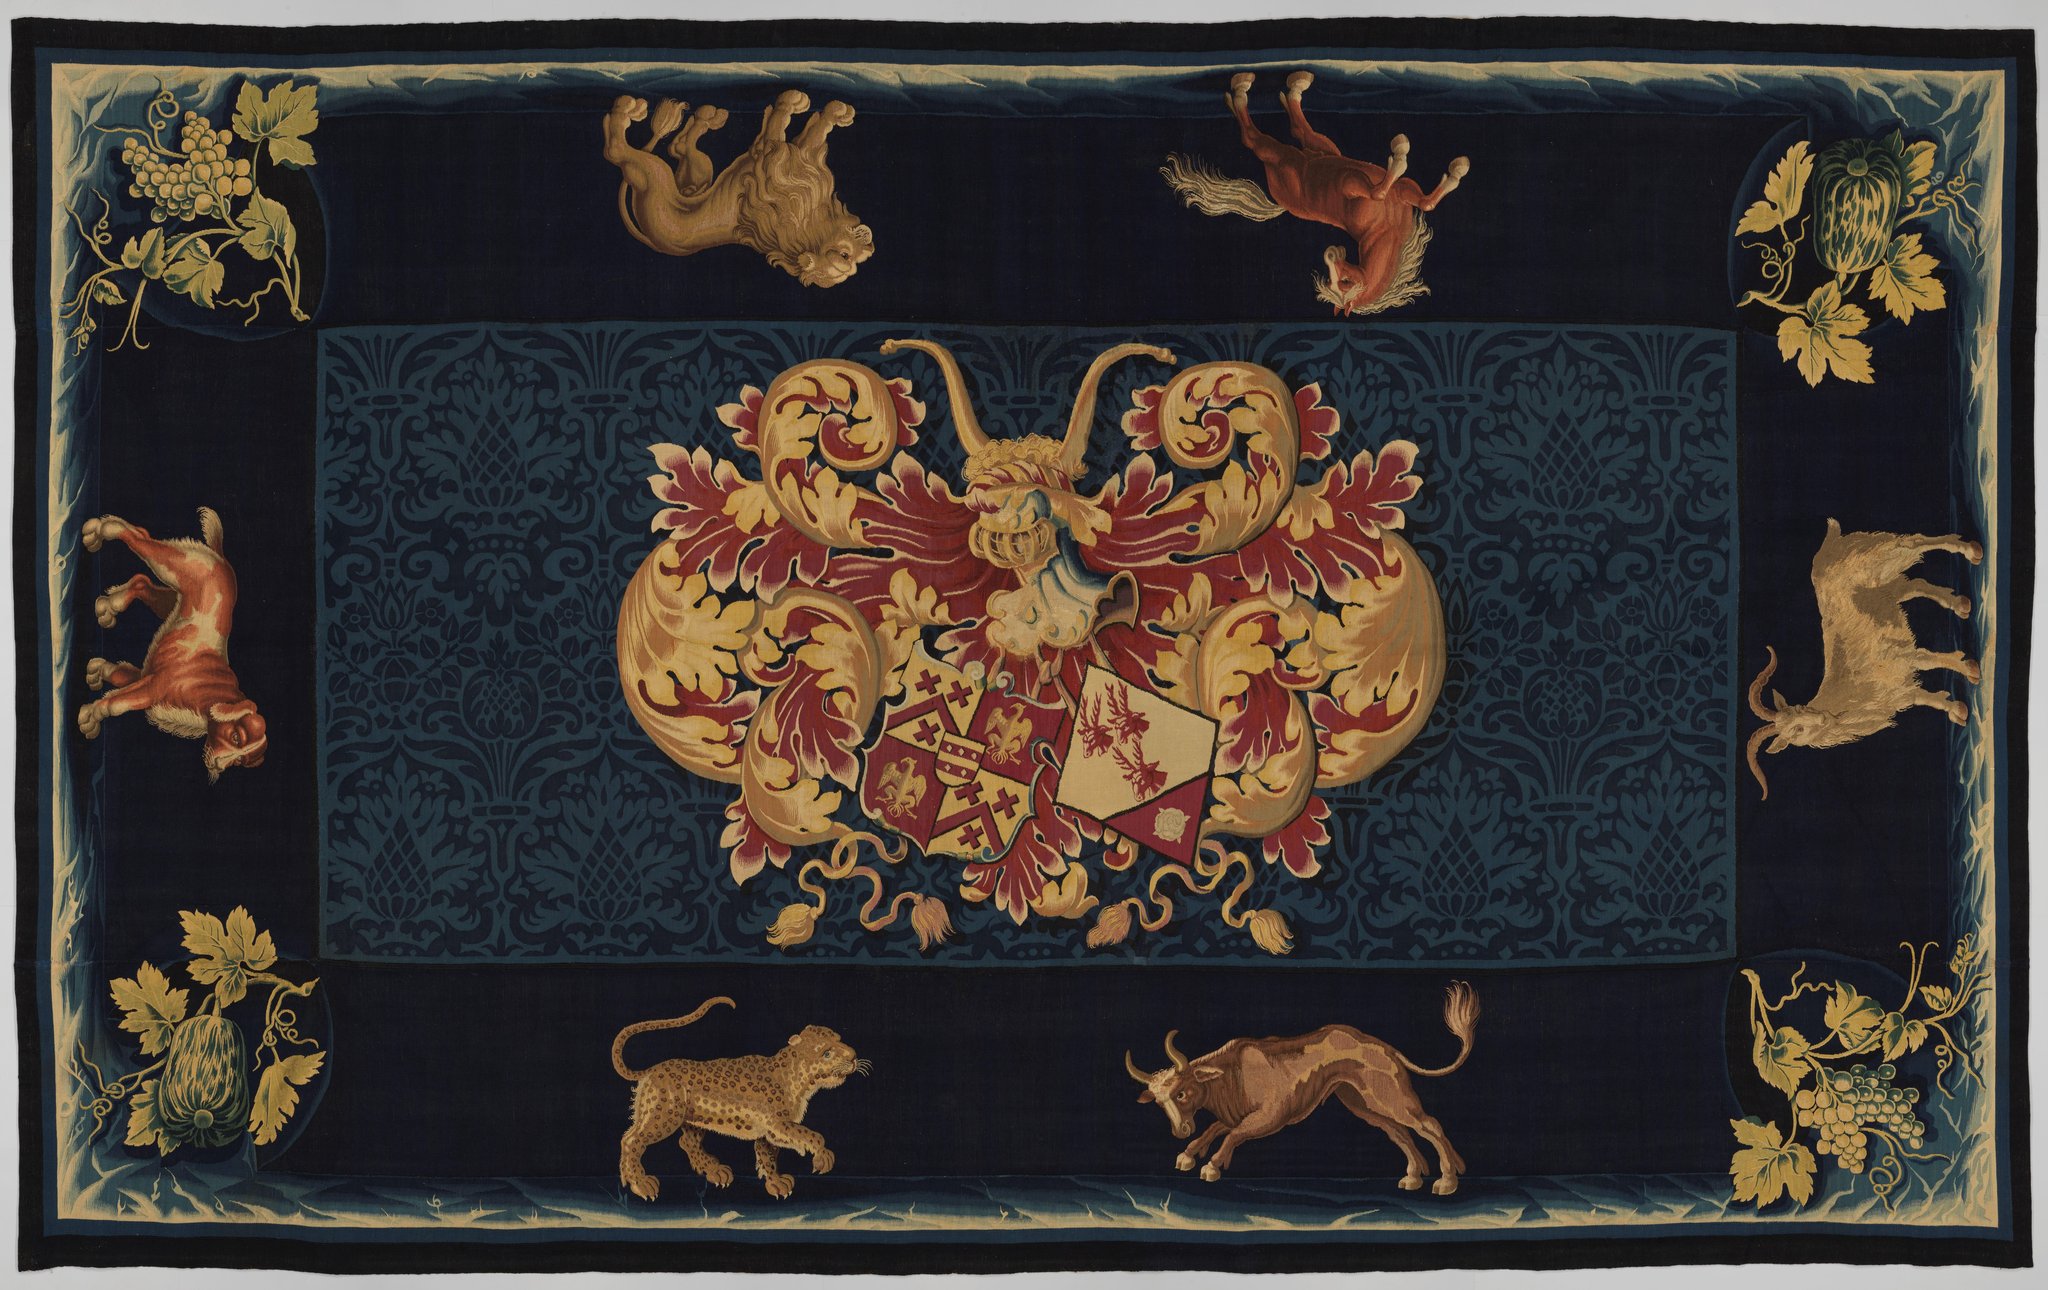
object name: tafelkleed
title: Familiewapens Oetgens van Waveren en Spiegel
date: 1624-1644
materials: linen, silk, wool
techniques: tapestry